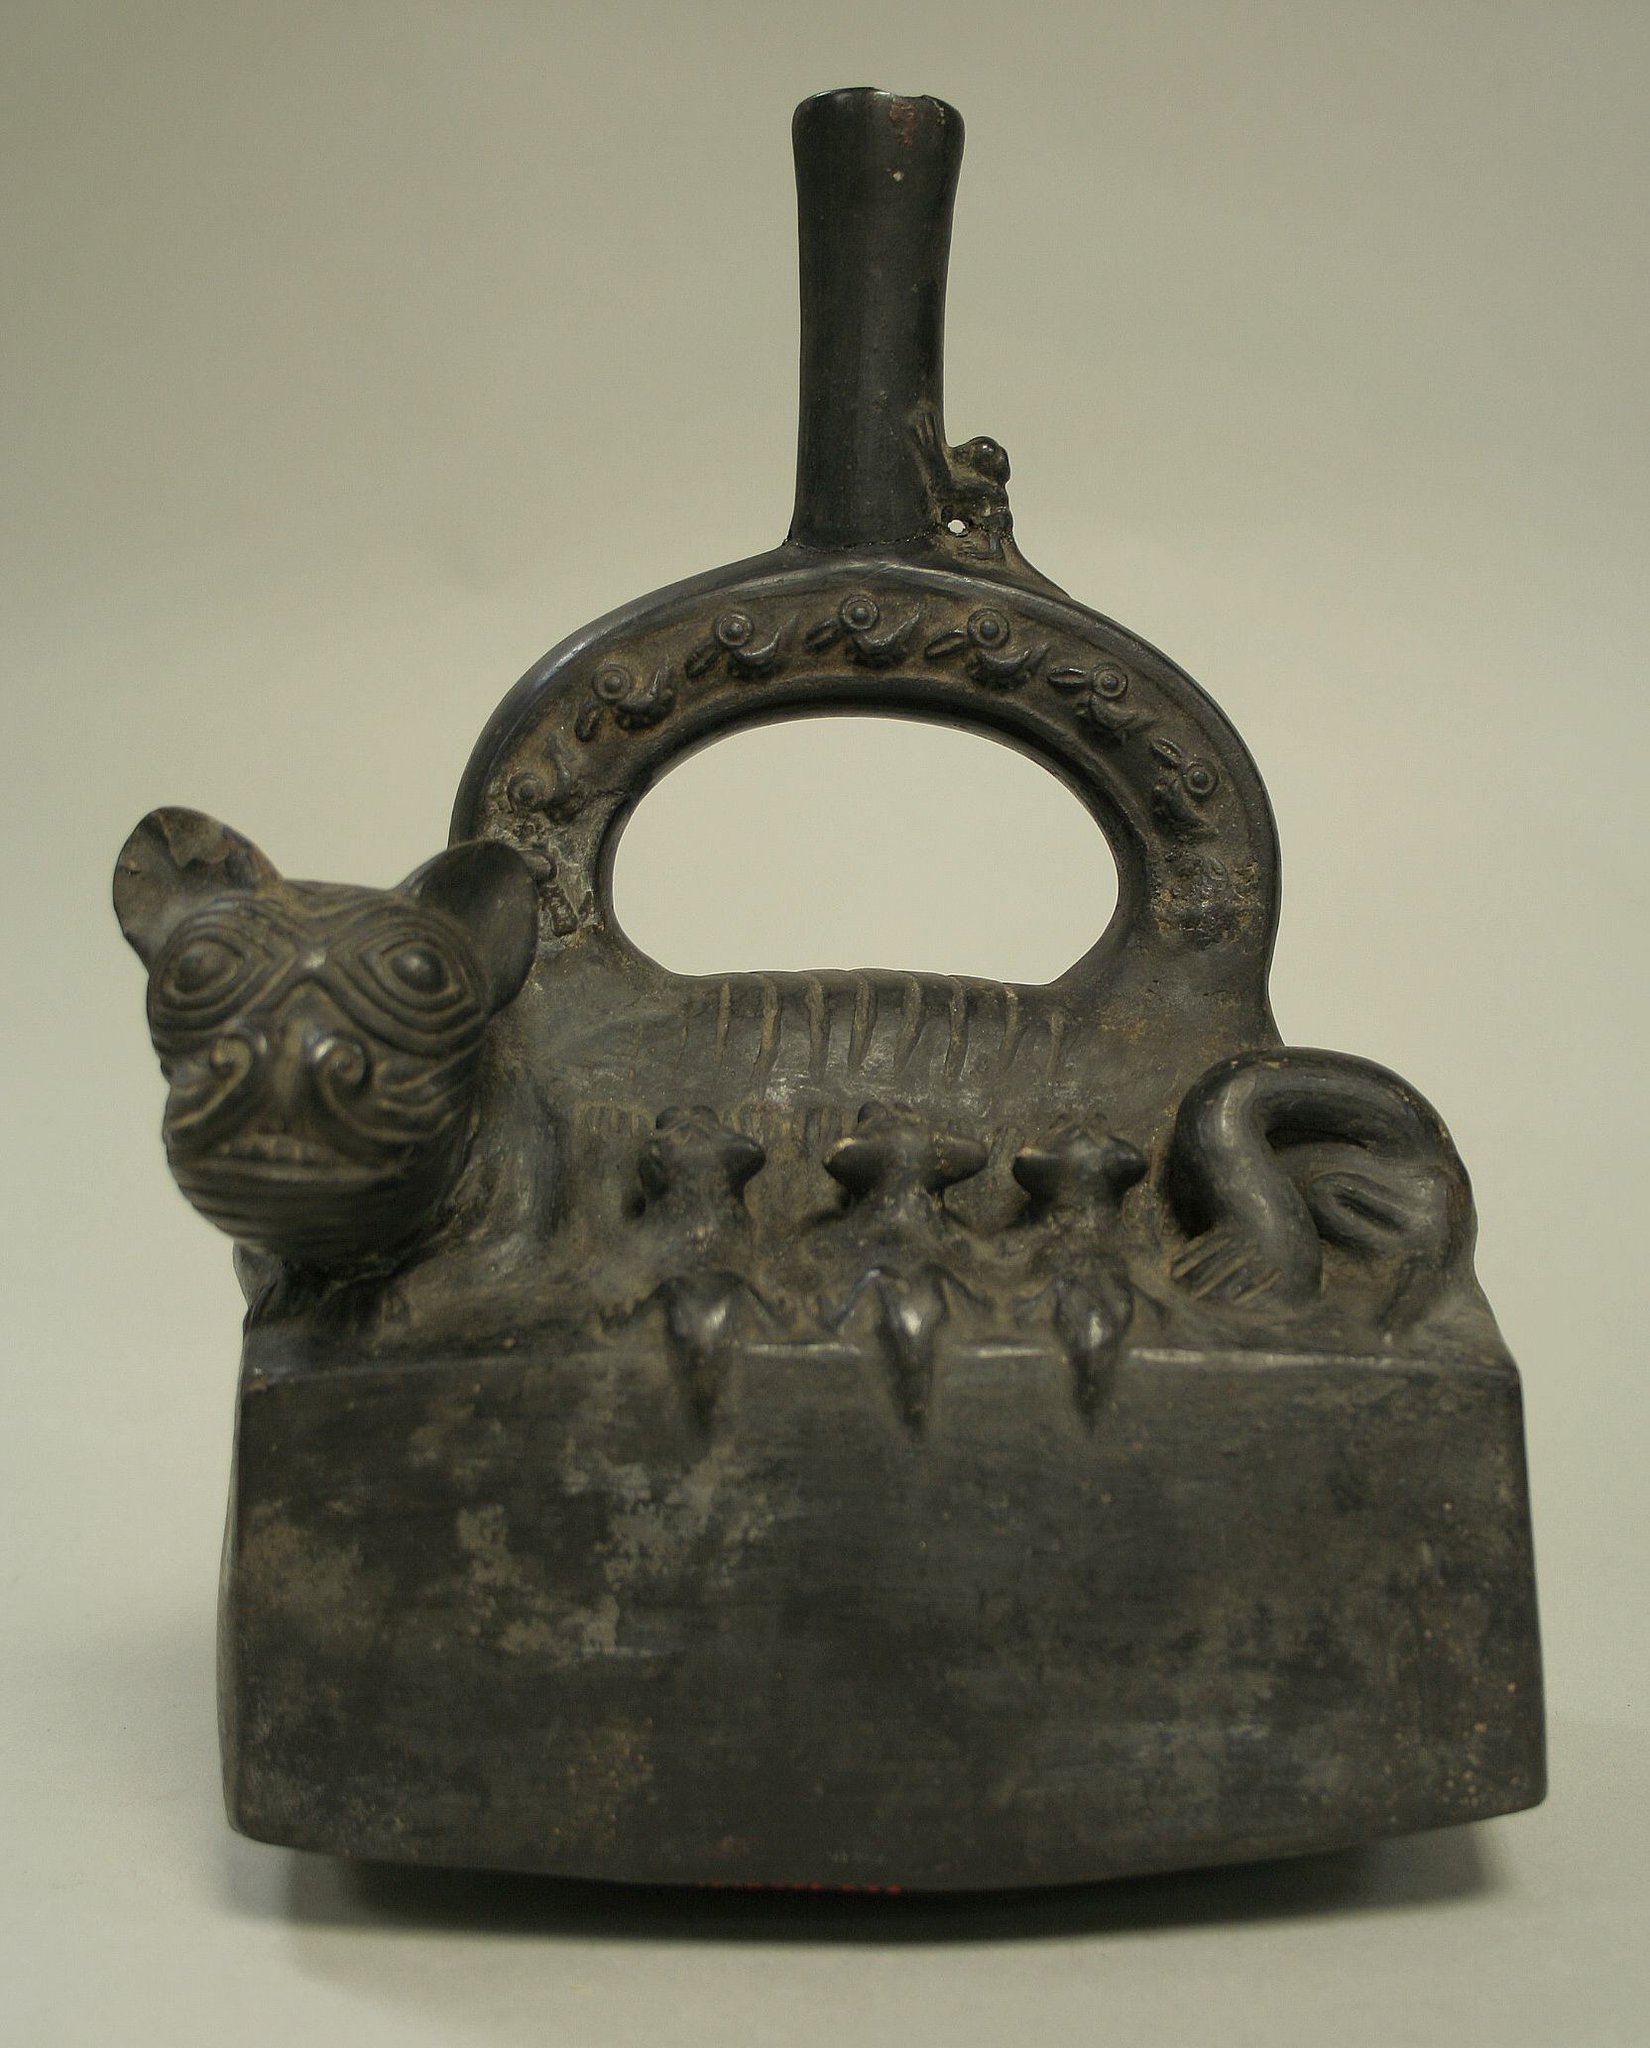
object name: bottle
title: Stirrup Spout Bottle with Suckling Puma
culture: chimú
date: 1101-1500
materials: ceramic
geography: peru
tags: animals